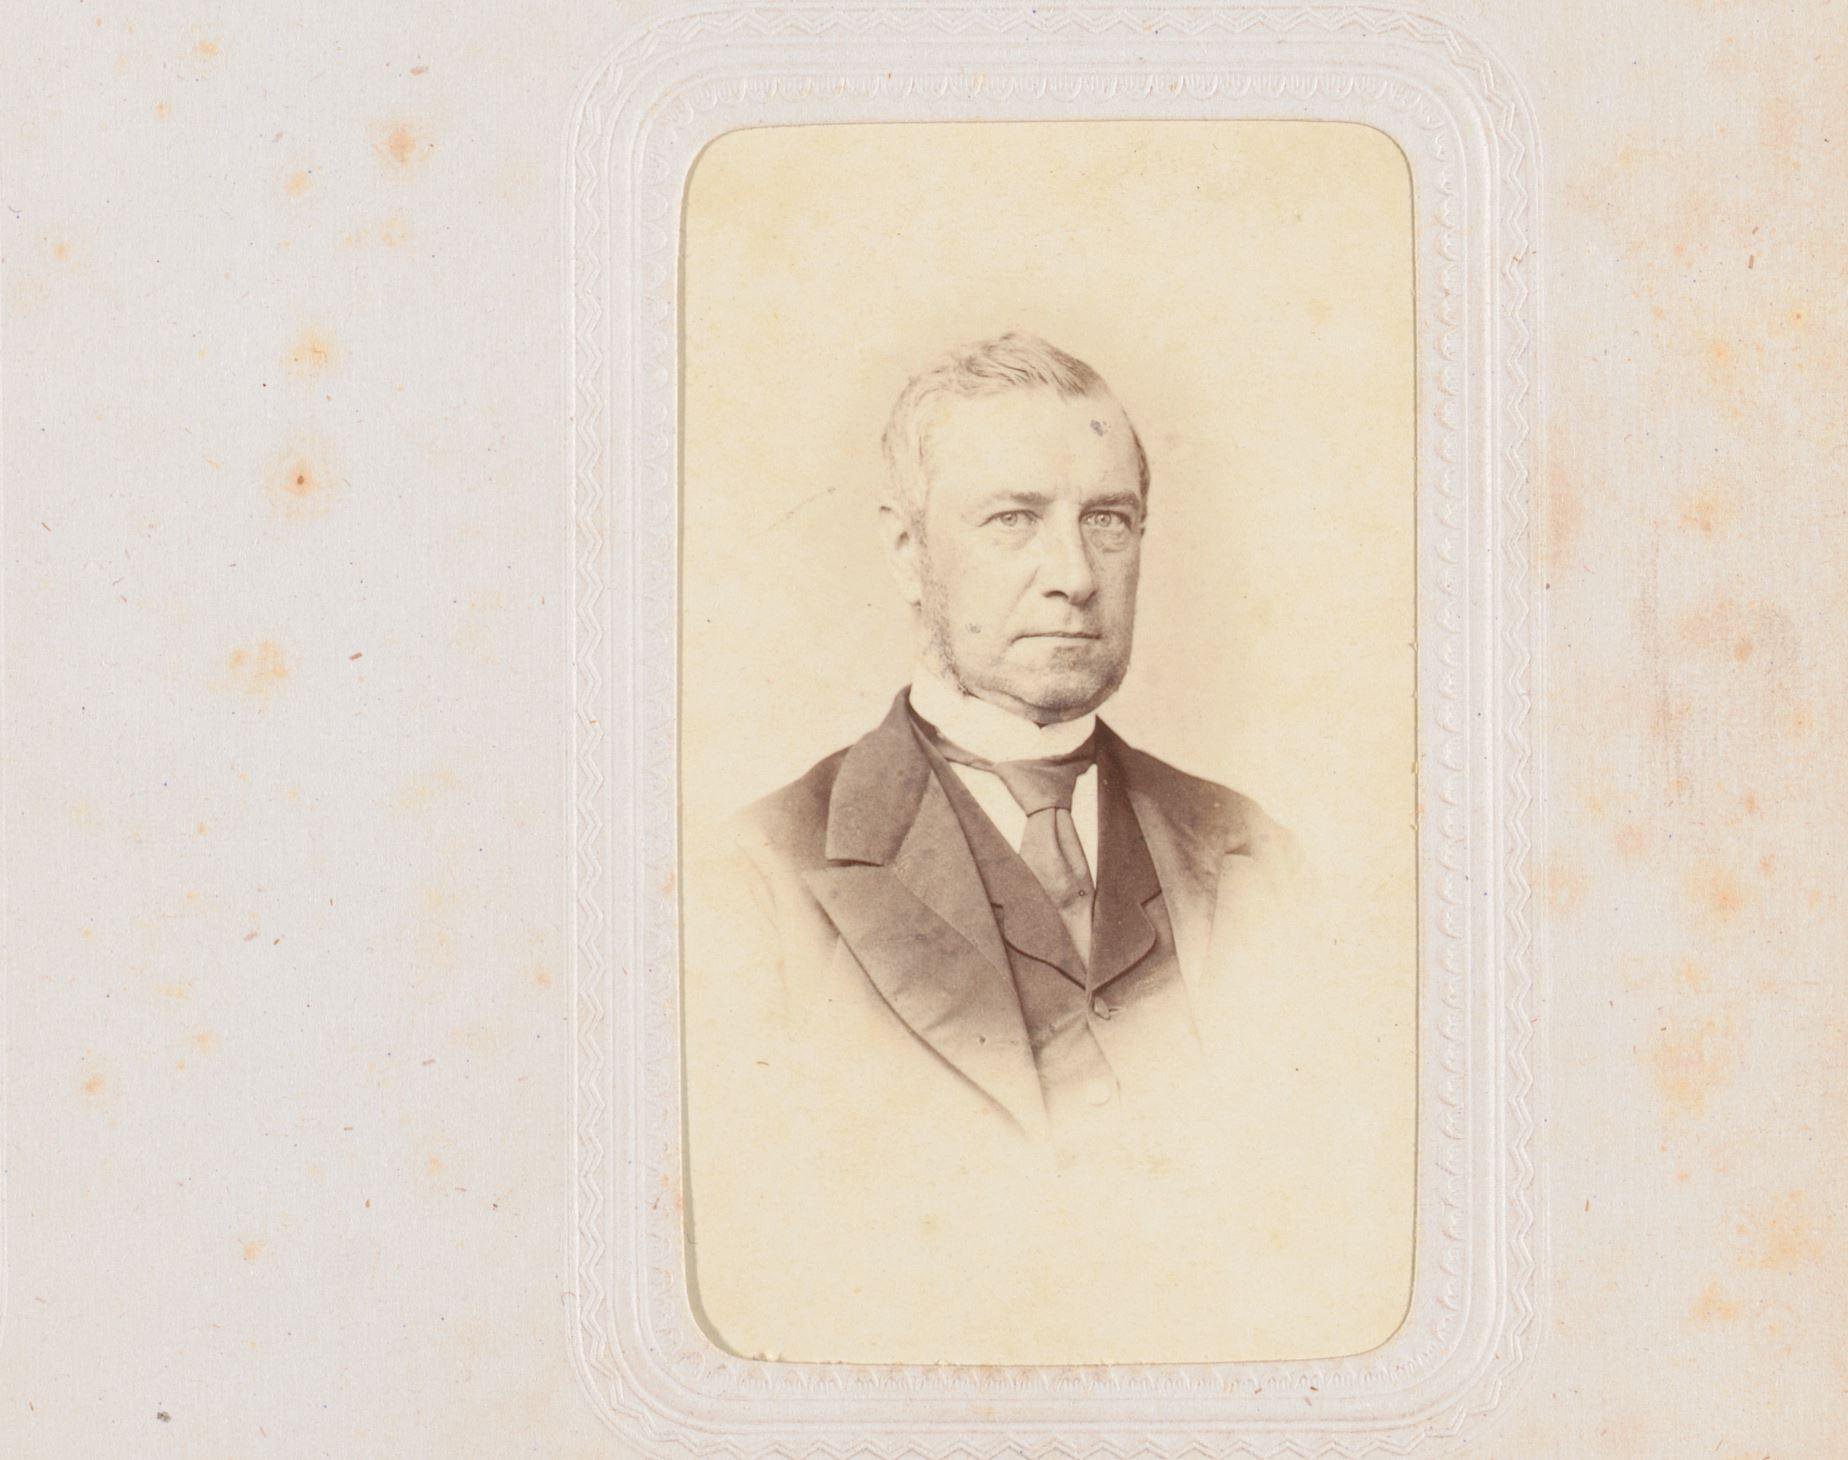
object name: album leaf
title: Portret van een man, aangeduid als W. Huijgens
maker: christiaan martinus jan hermelink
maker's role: fotograaf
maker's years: 1840-1933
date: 1867-1885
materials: cardboard, photographic support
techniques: albumen print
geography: the hague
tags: historical persons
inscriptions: name: ‘Huigens’, inscription: ‘C.M.J. HERMELINK/ 62, Denneweg/ S' GRAVENHAGE’, annotation: ‘W.Huijgens [...]/ Directr. Y. P. v. O.’